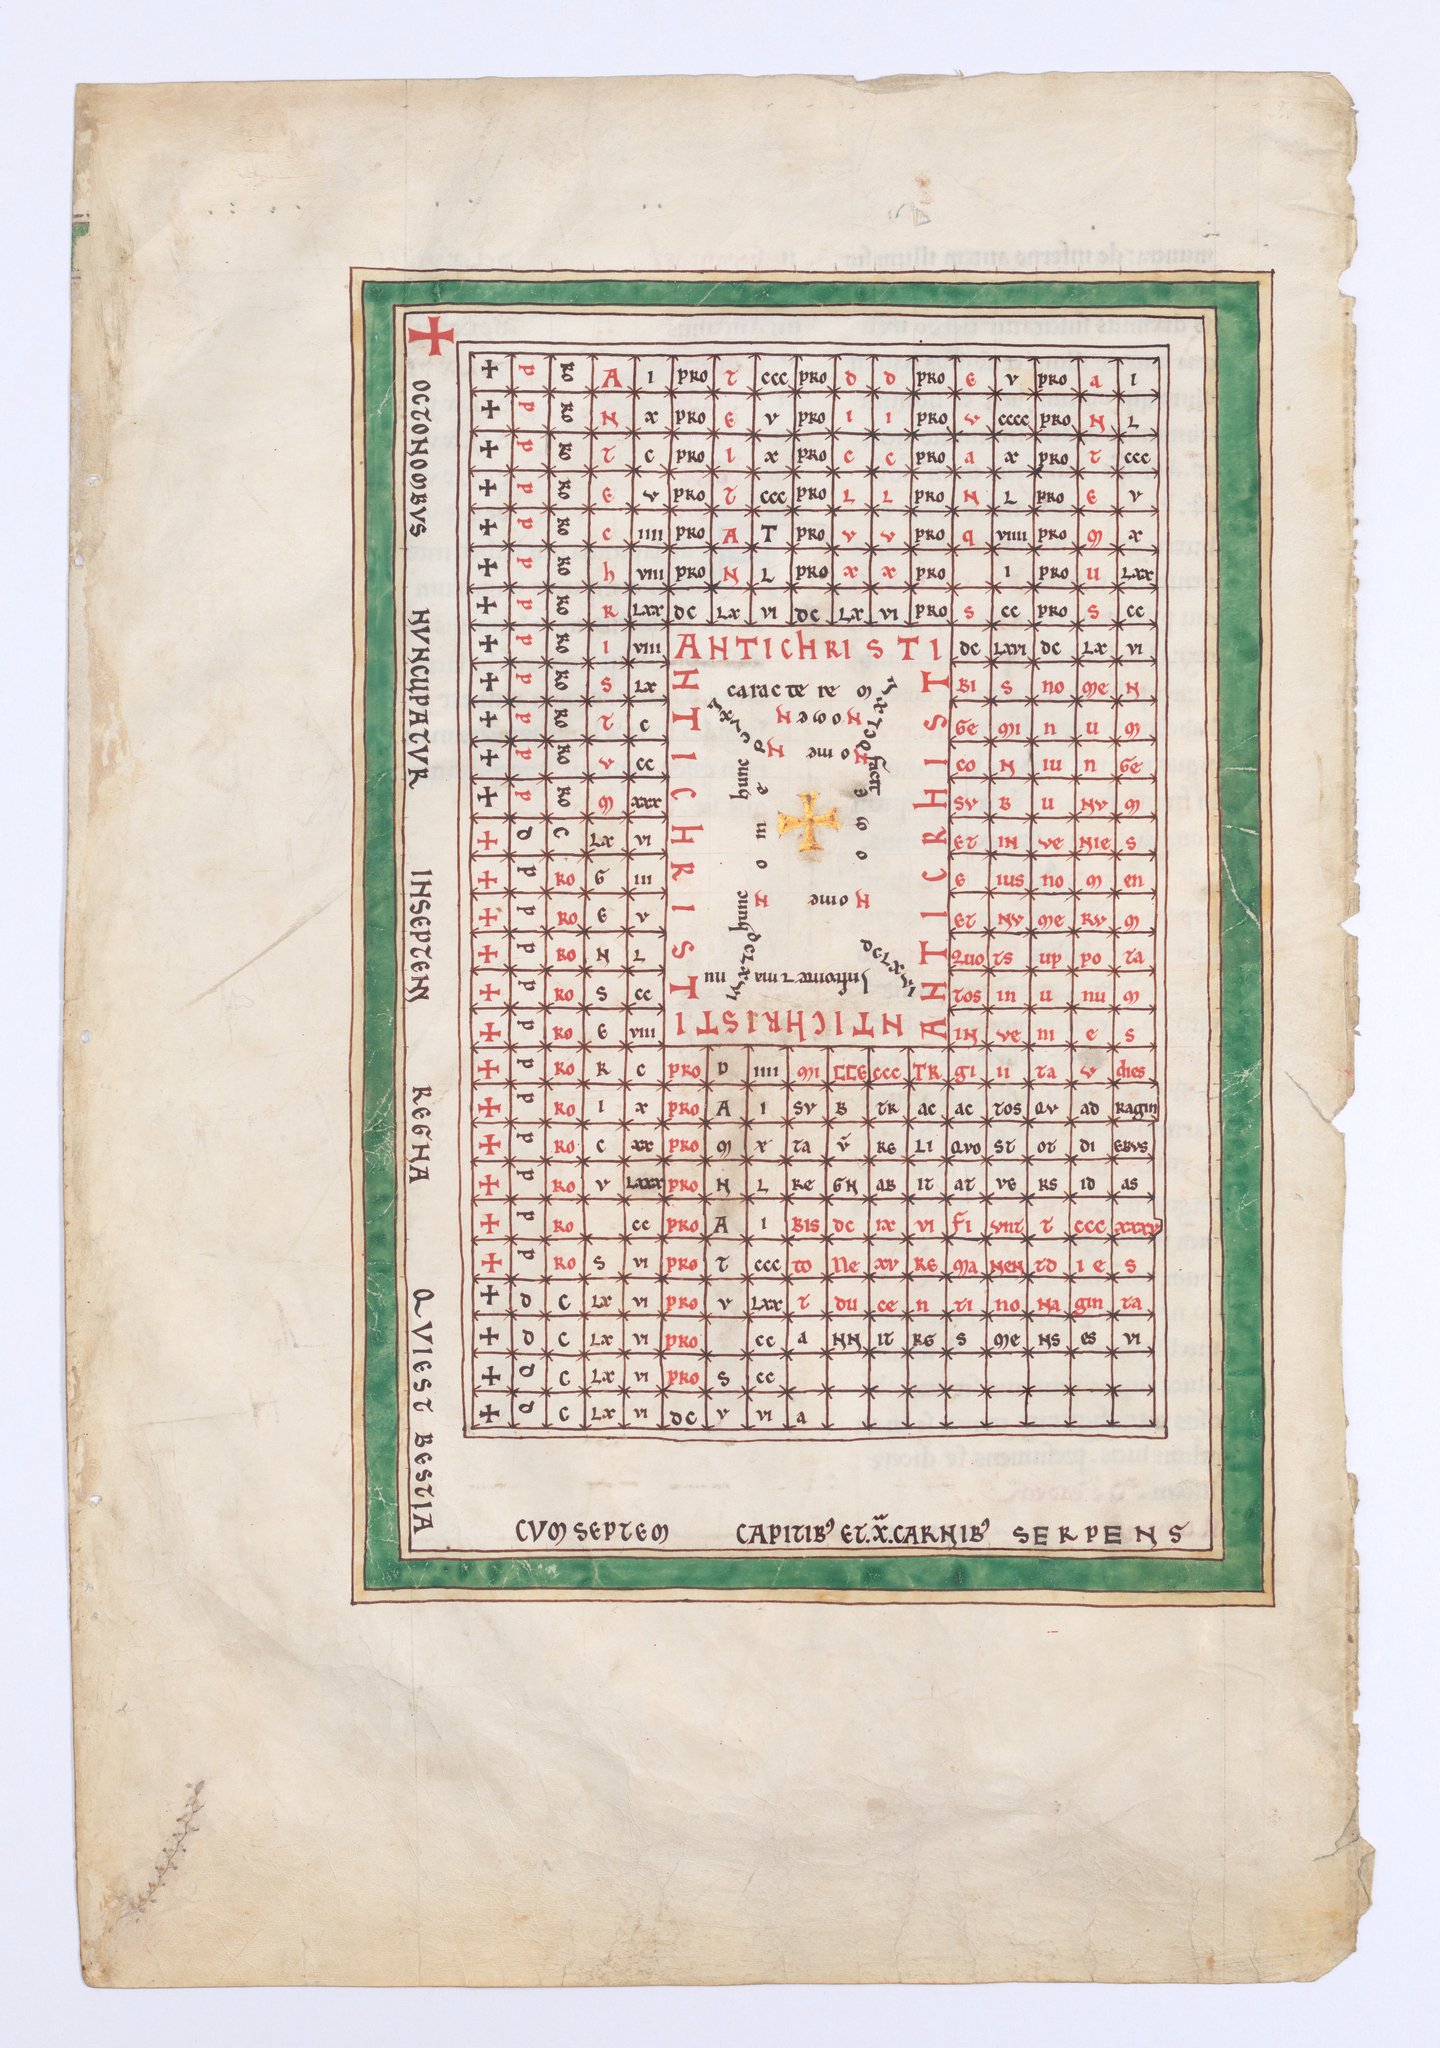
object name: beatus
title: Leaf from a Beatus Manuscript: Table of the Antichrist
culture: spanish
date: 1180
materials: gold, ink, parchment, paint